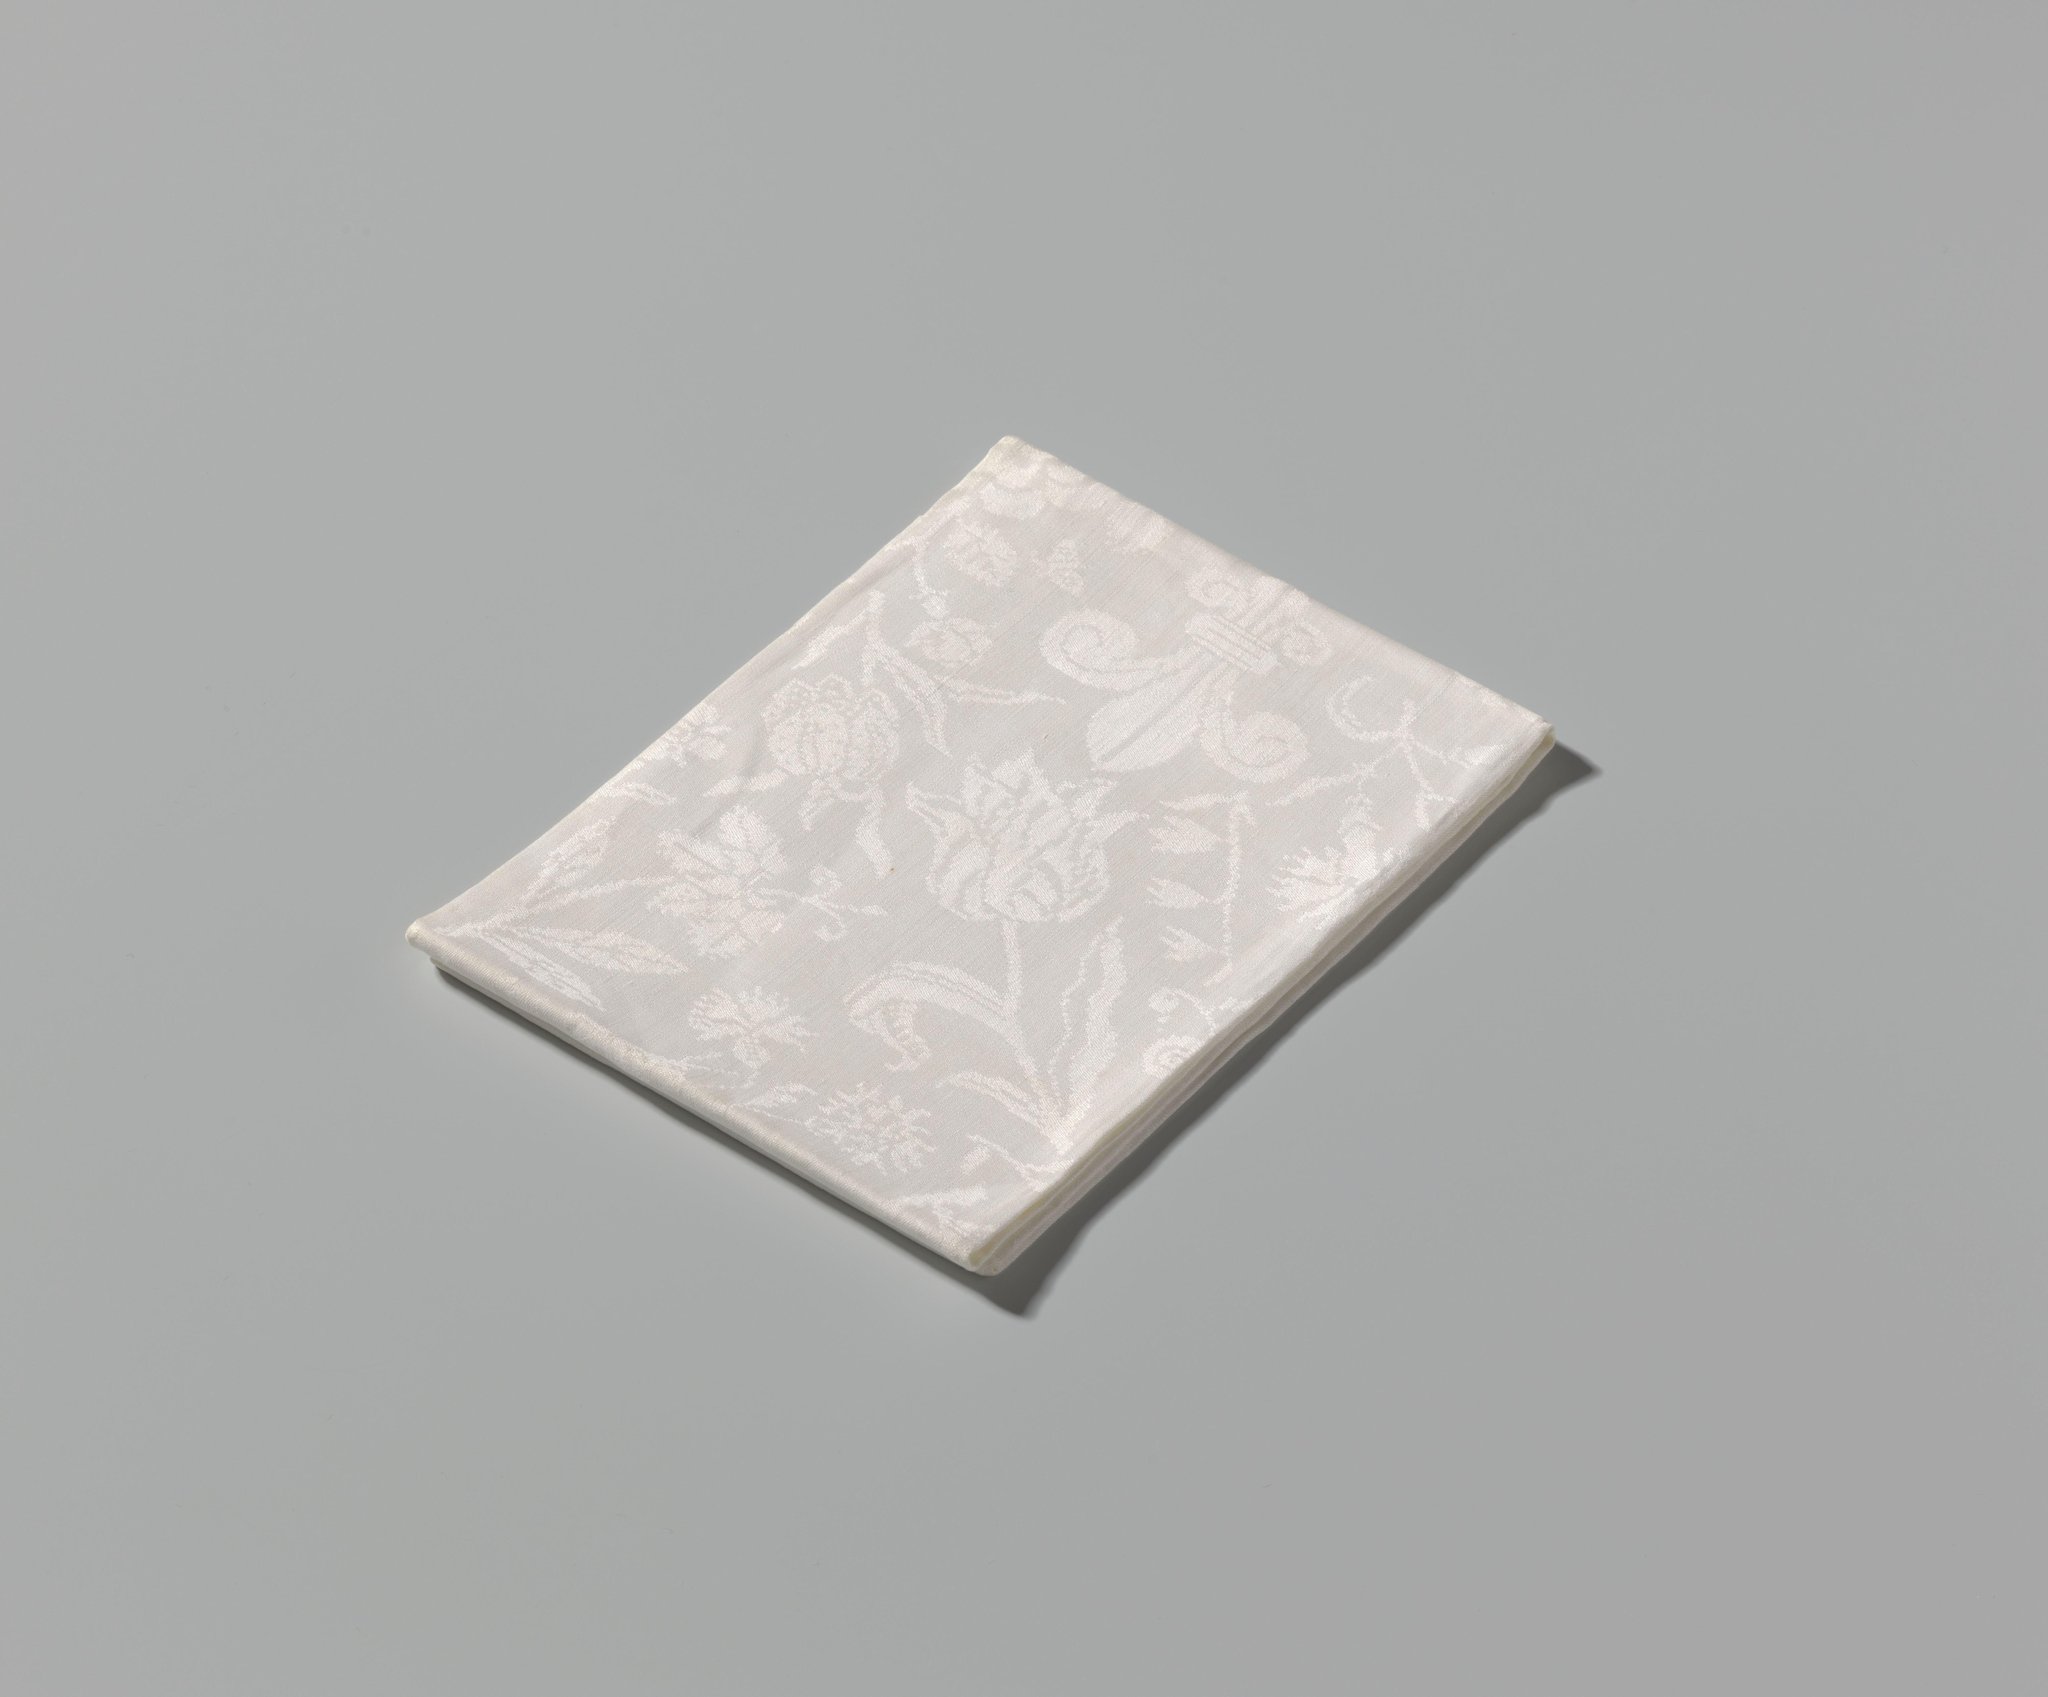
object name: napkin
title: Servet van wit linnendamast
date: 1640-1660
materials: linen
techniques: damask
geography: northern netherlands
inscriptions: mark: ‘DvdM 40’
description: Witlinnen damasten servet met een patroon van gestrooide bloemen en een fleur de lis, gemerkt DvdM 40.